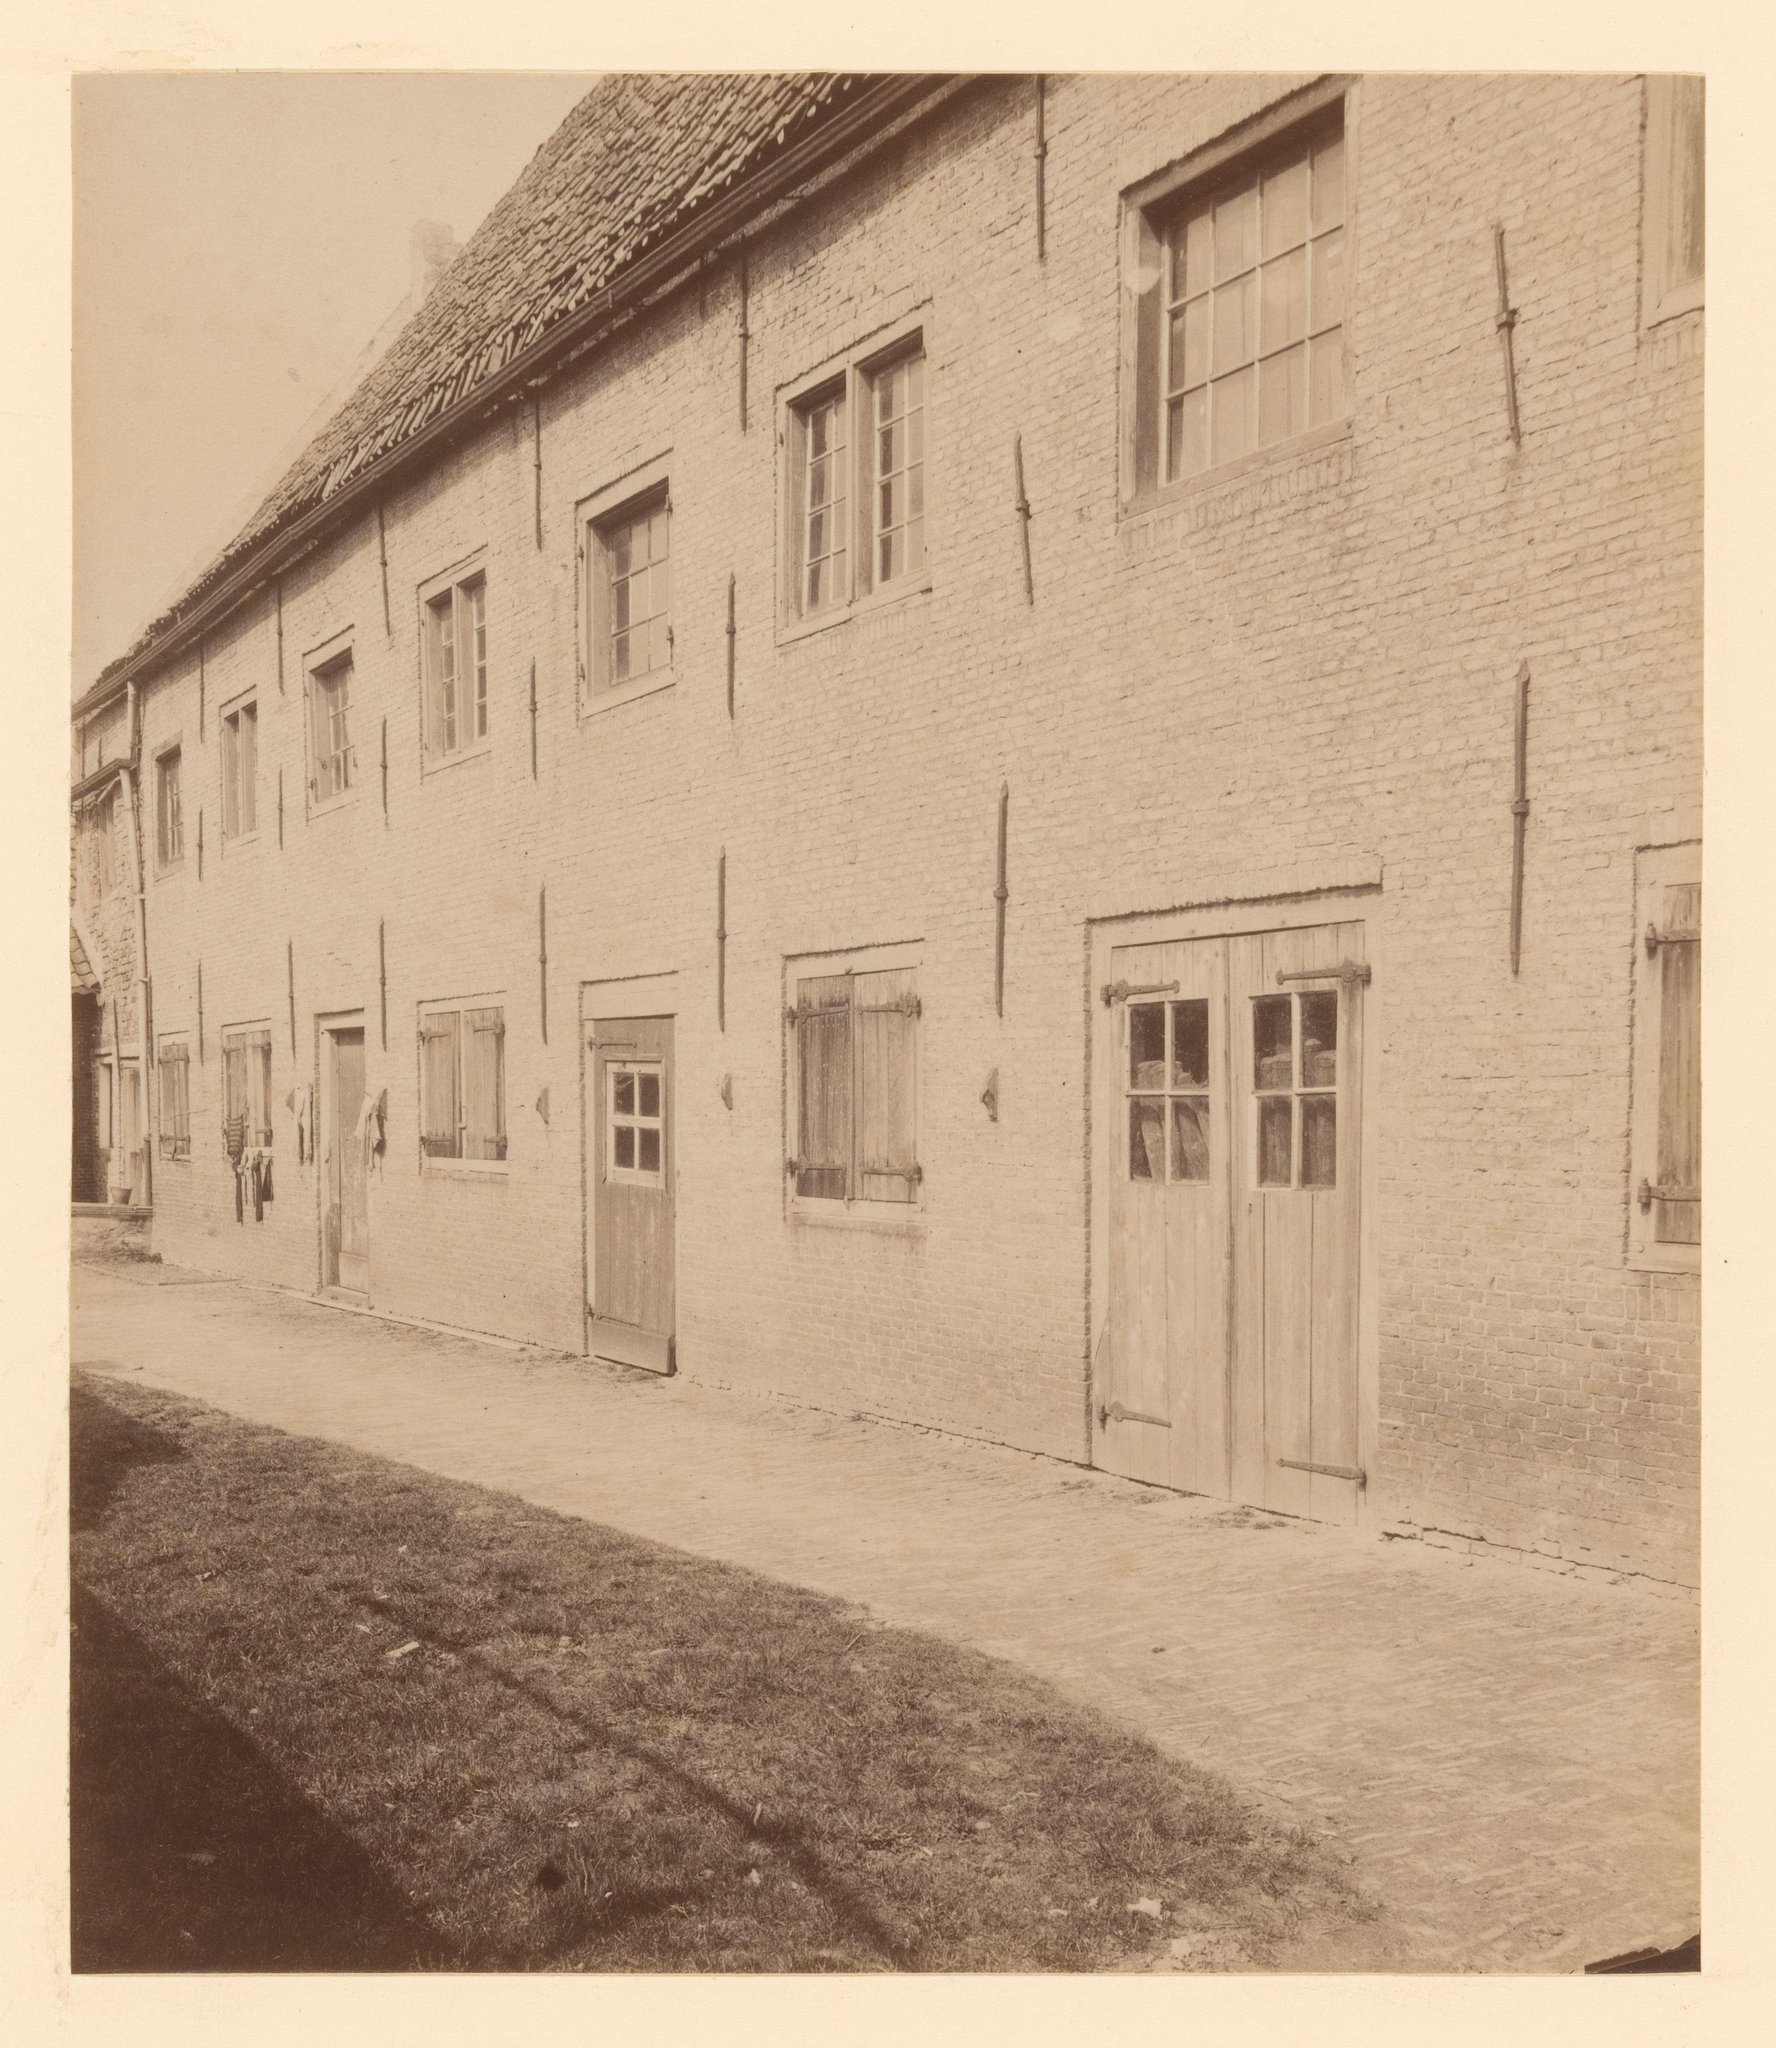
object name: photograph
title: Zuidelijke gevel van de Begijnhofkapel te Bolsward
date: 1902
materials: cardboard, photographic support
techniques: albumen print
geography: bolsward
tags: parts of church exterior and annexes: chapel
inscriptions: annotation: ‘Begijnenhofkapel / zuidelijke gevel / Bolsward april 1902’, annotation: ‘Bolsward’